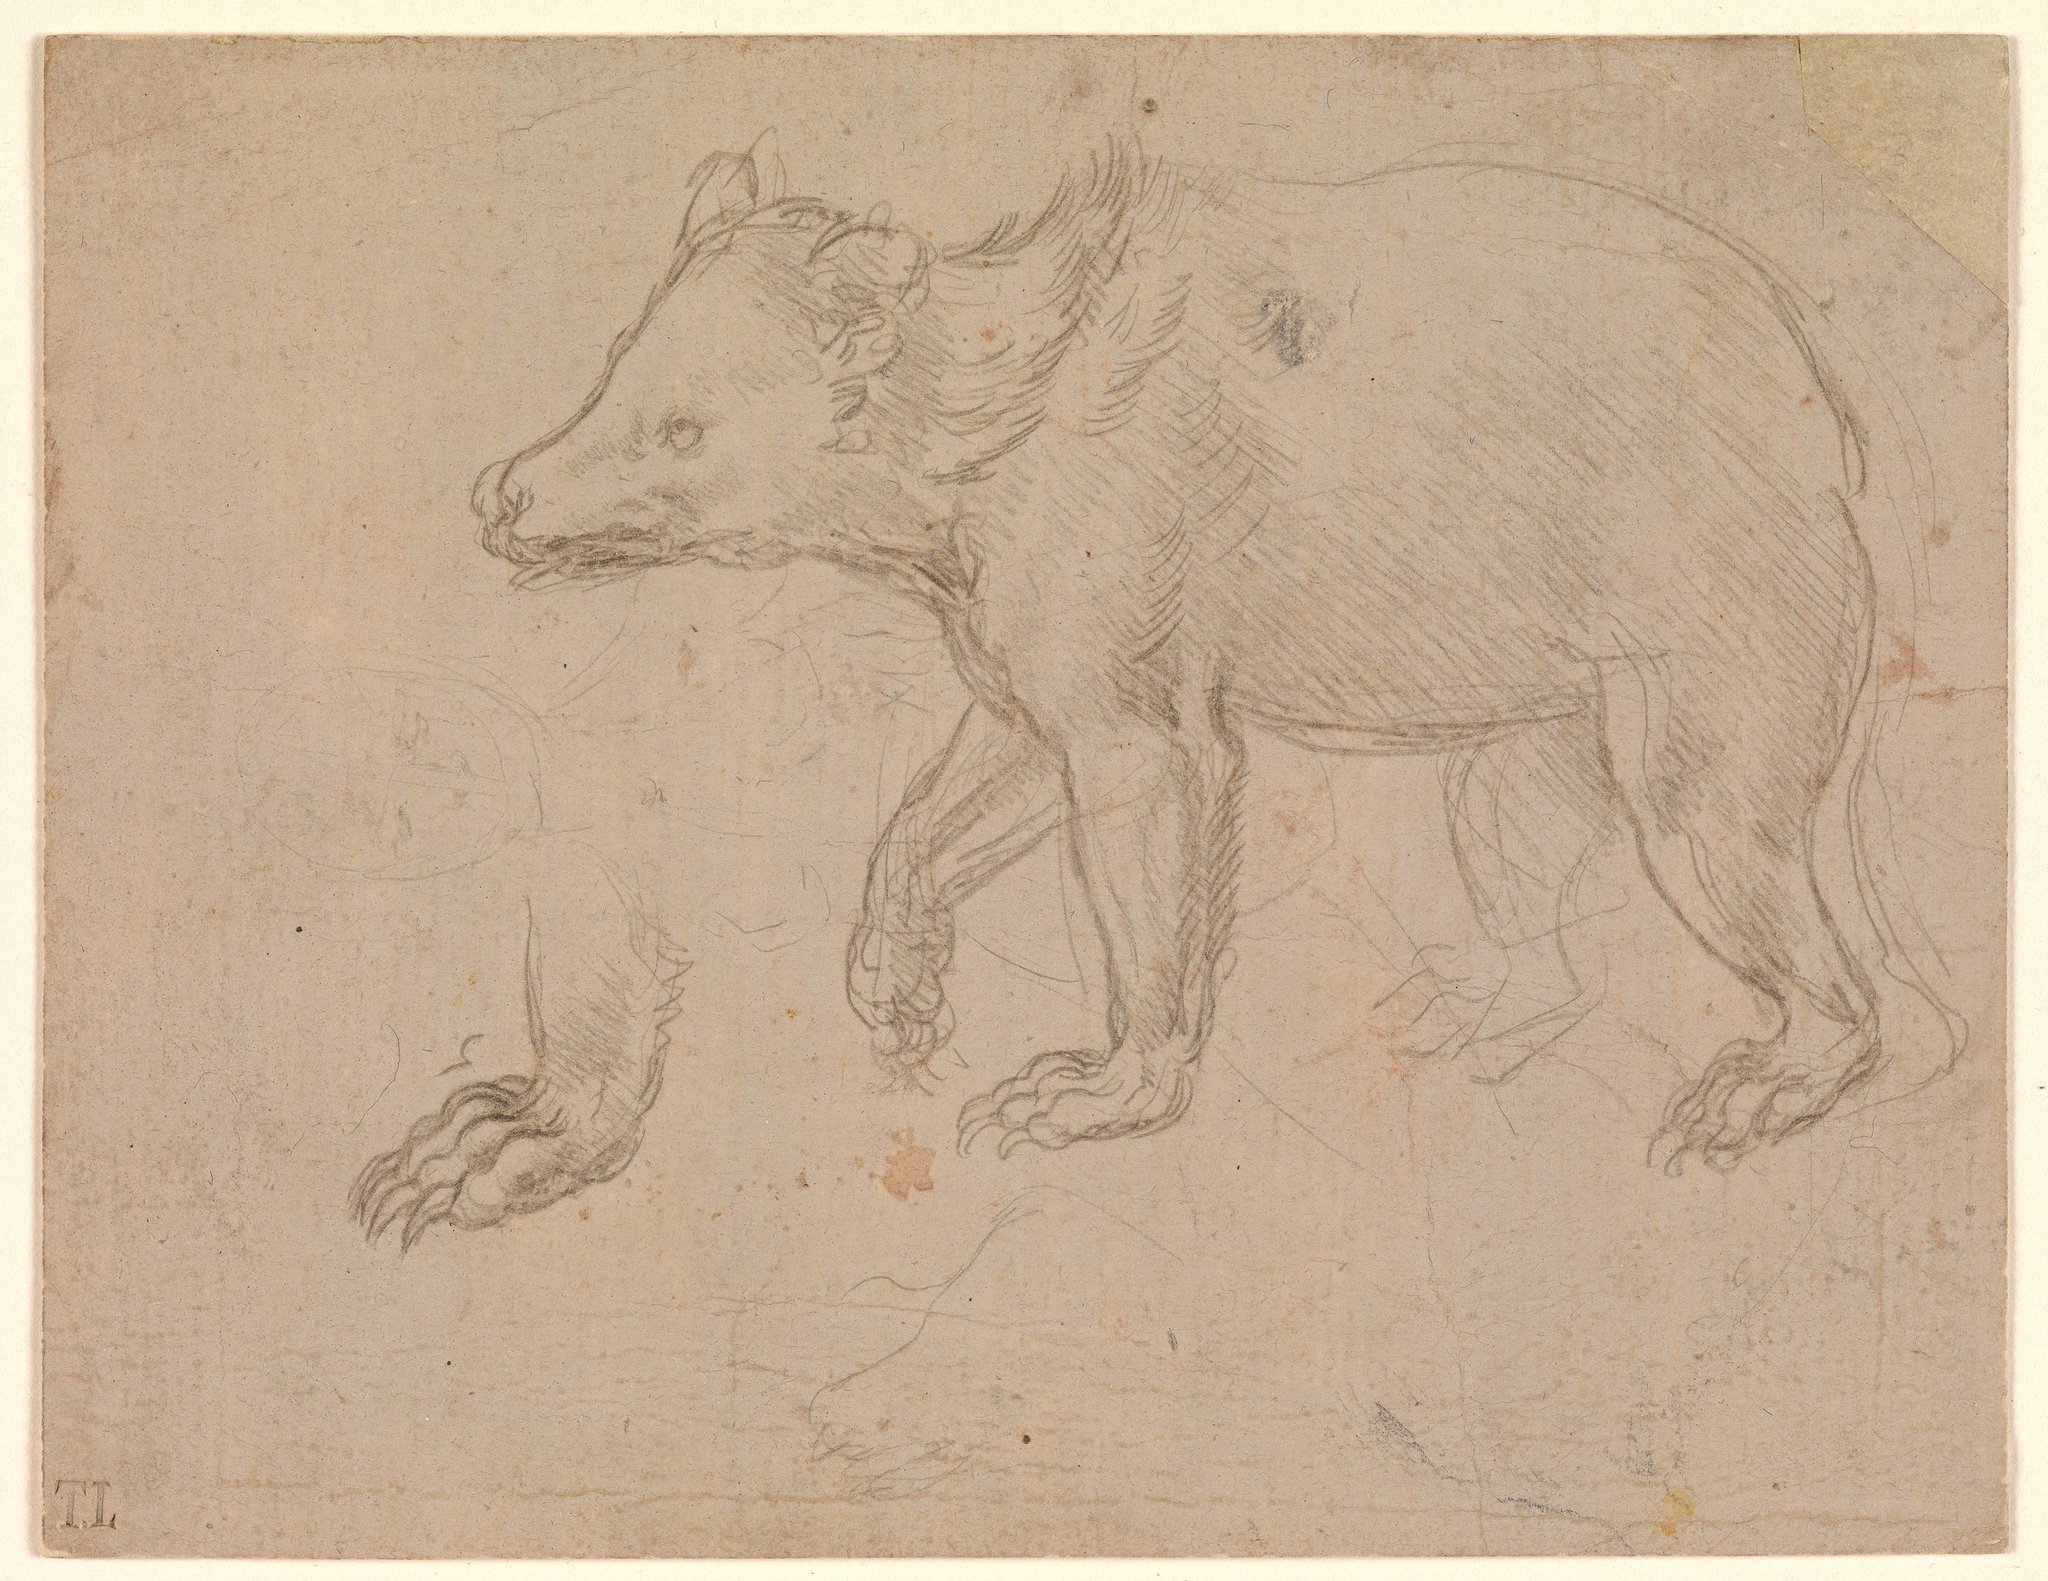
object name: drawing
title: A Bear Walking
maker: leonardo da vinci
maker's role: artist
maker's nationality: italian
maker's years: 1452-1519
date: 1482-1485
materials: paper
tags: bears